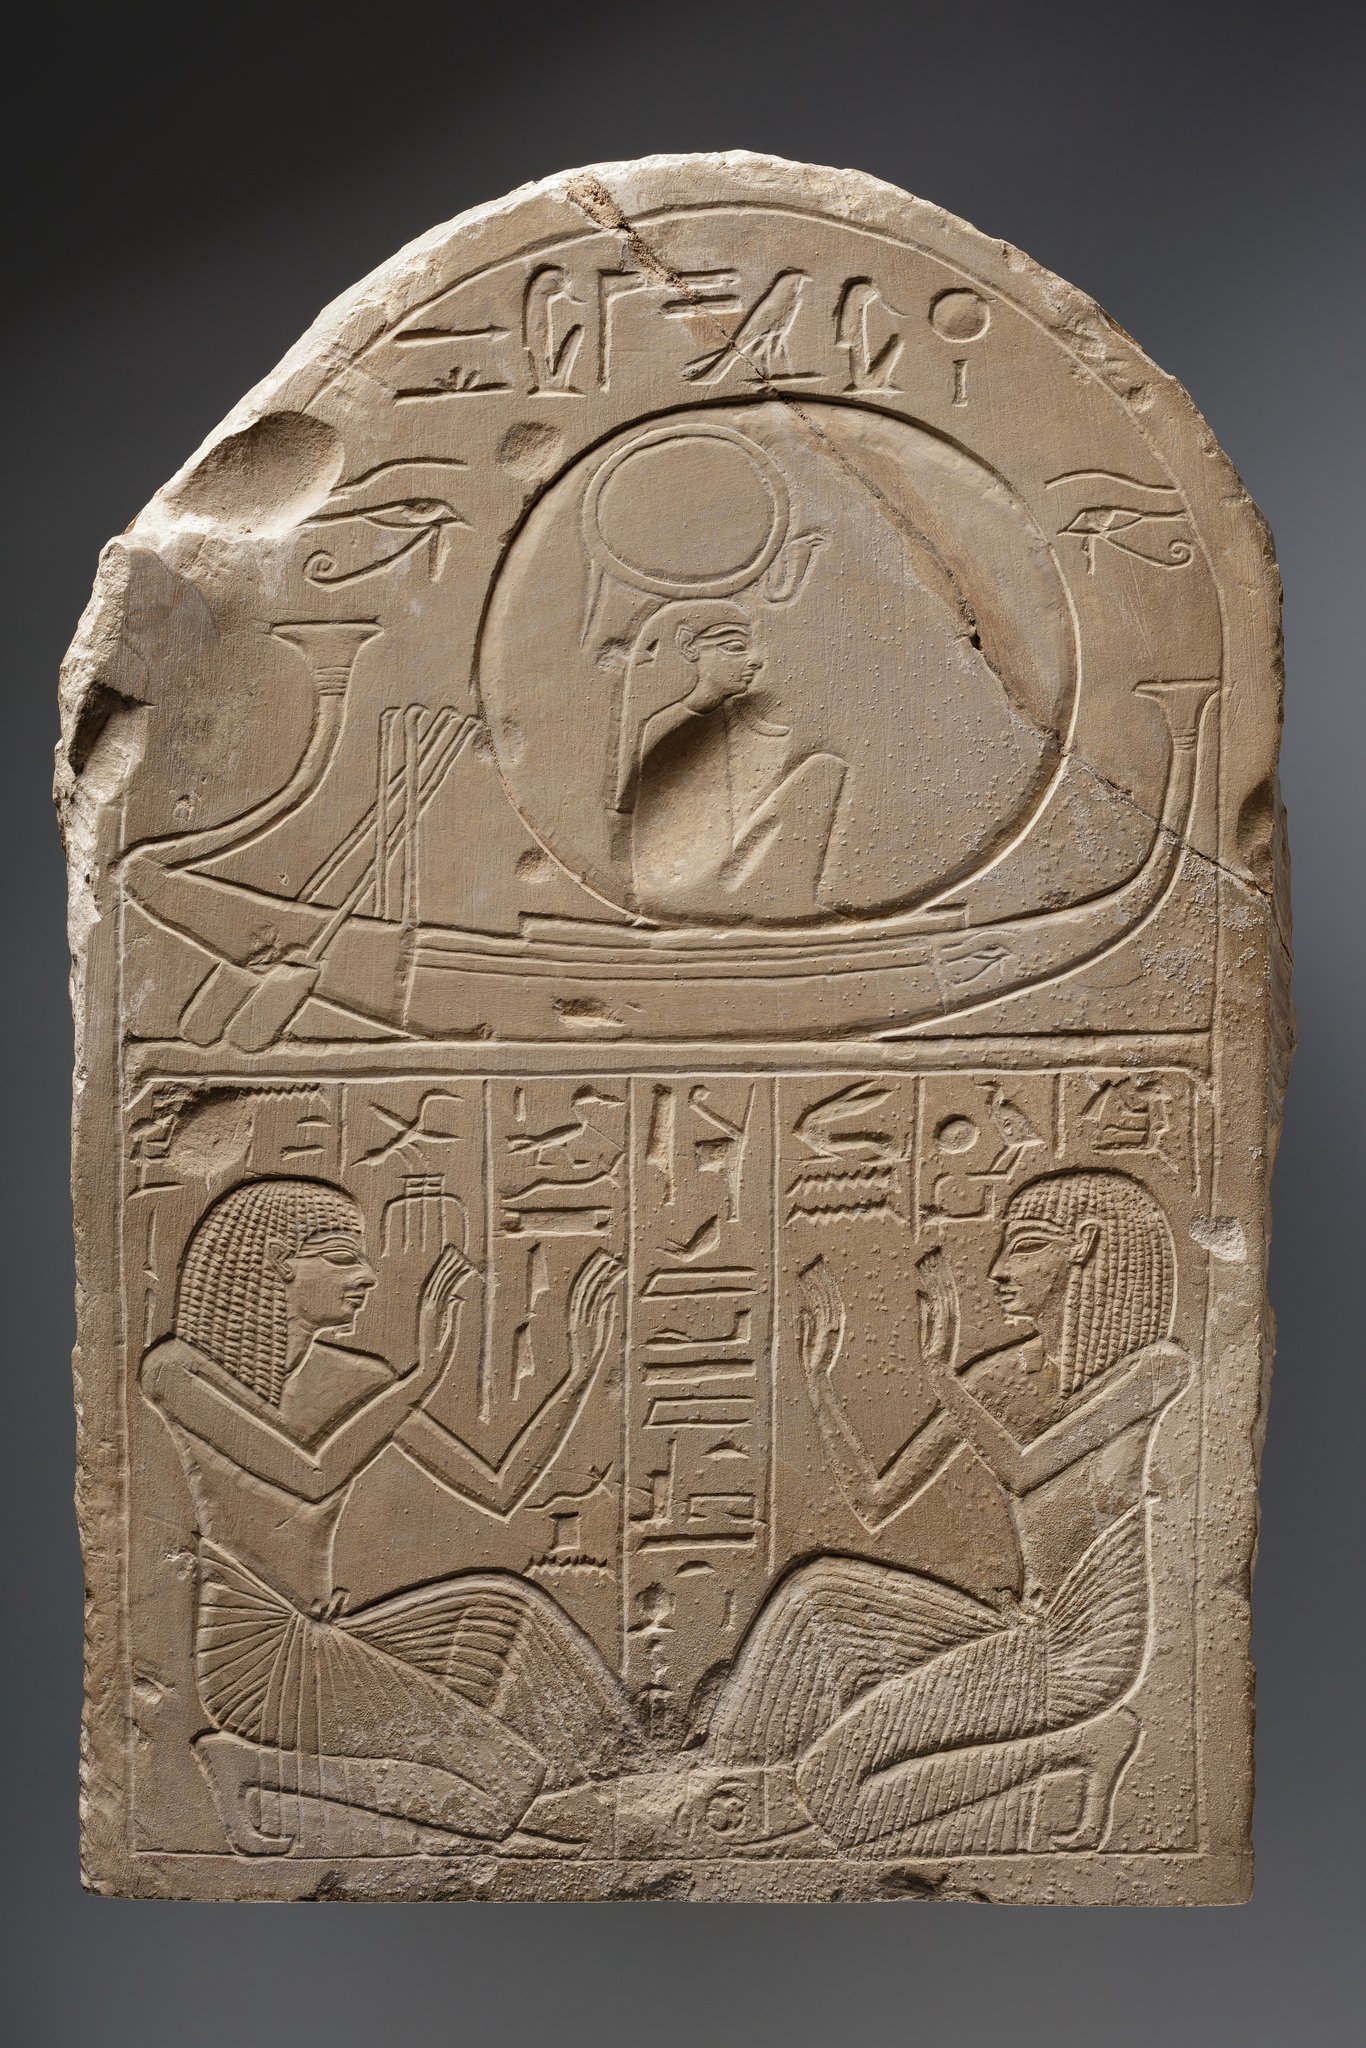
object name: stela, wenenkhu, penpakhenty, re harakhty, solar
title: Round-topped Stela of Wenenkhu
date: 1275-1237 BCE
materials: limestone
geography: upper egypt, thebes